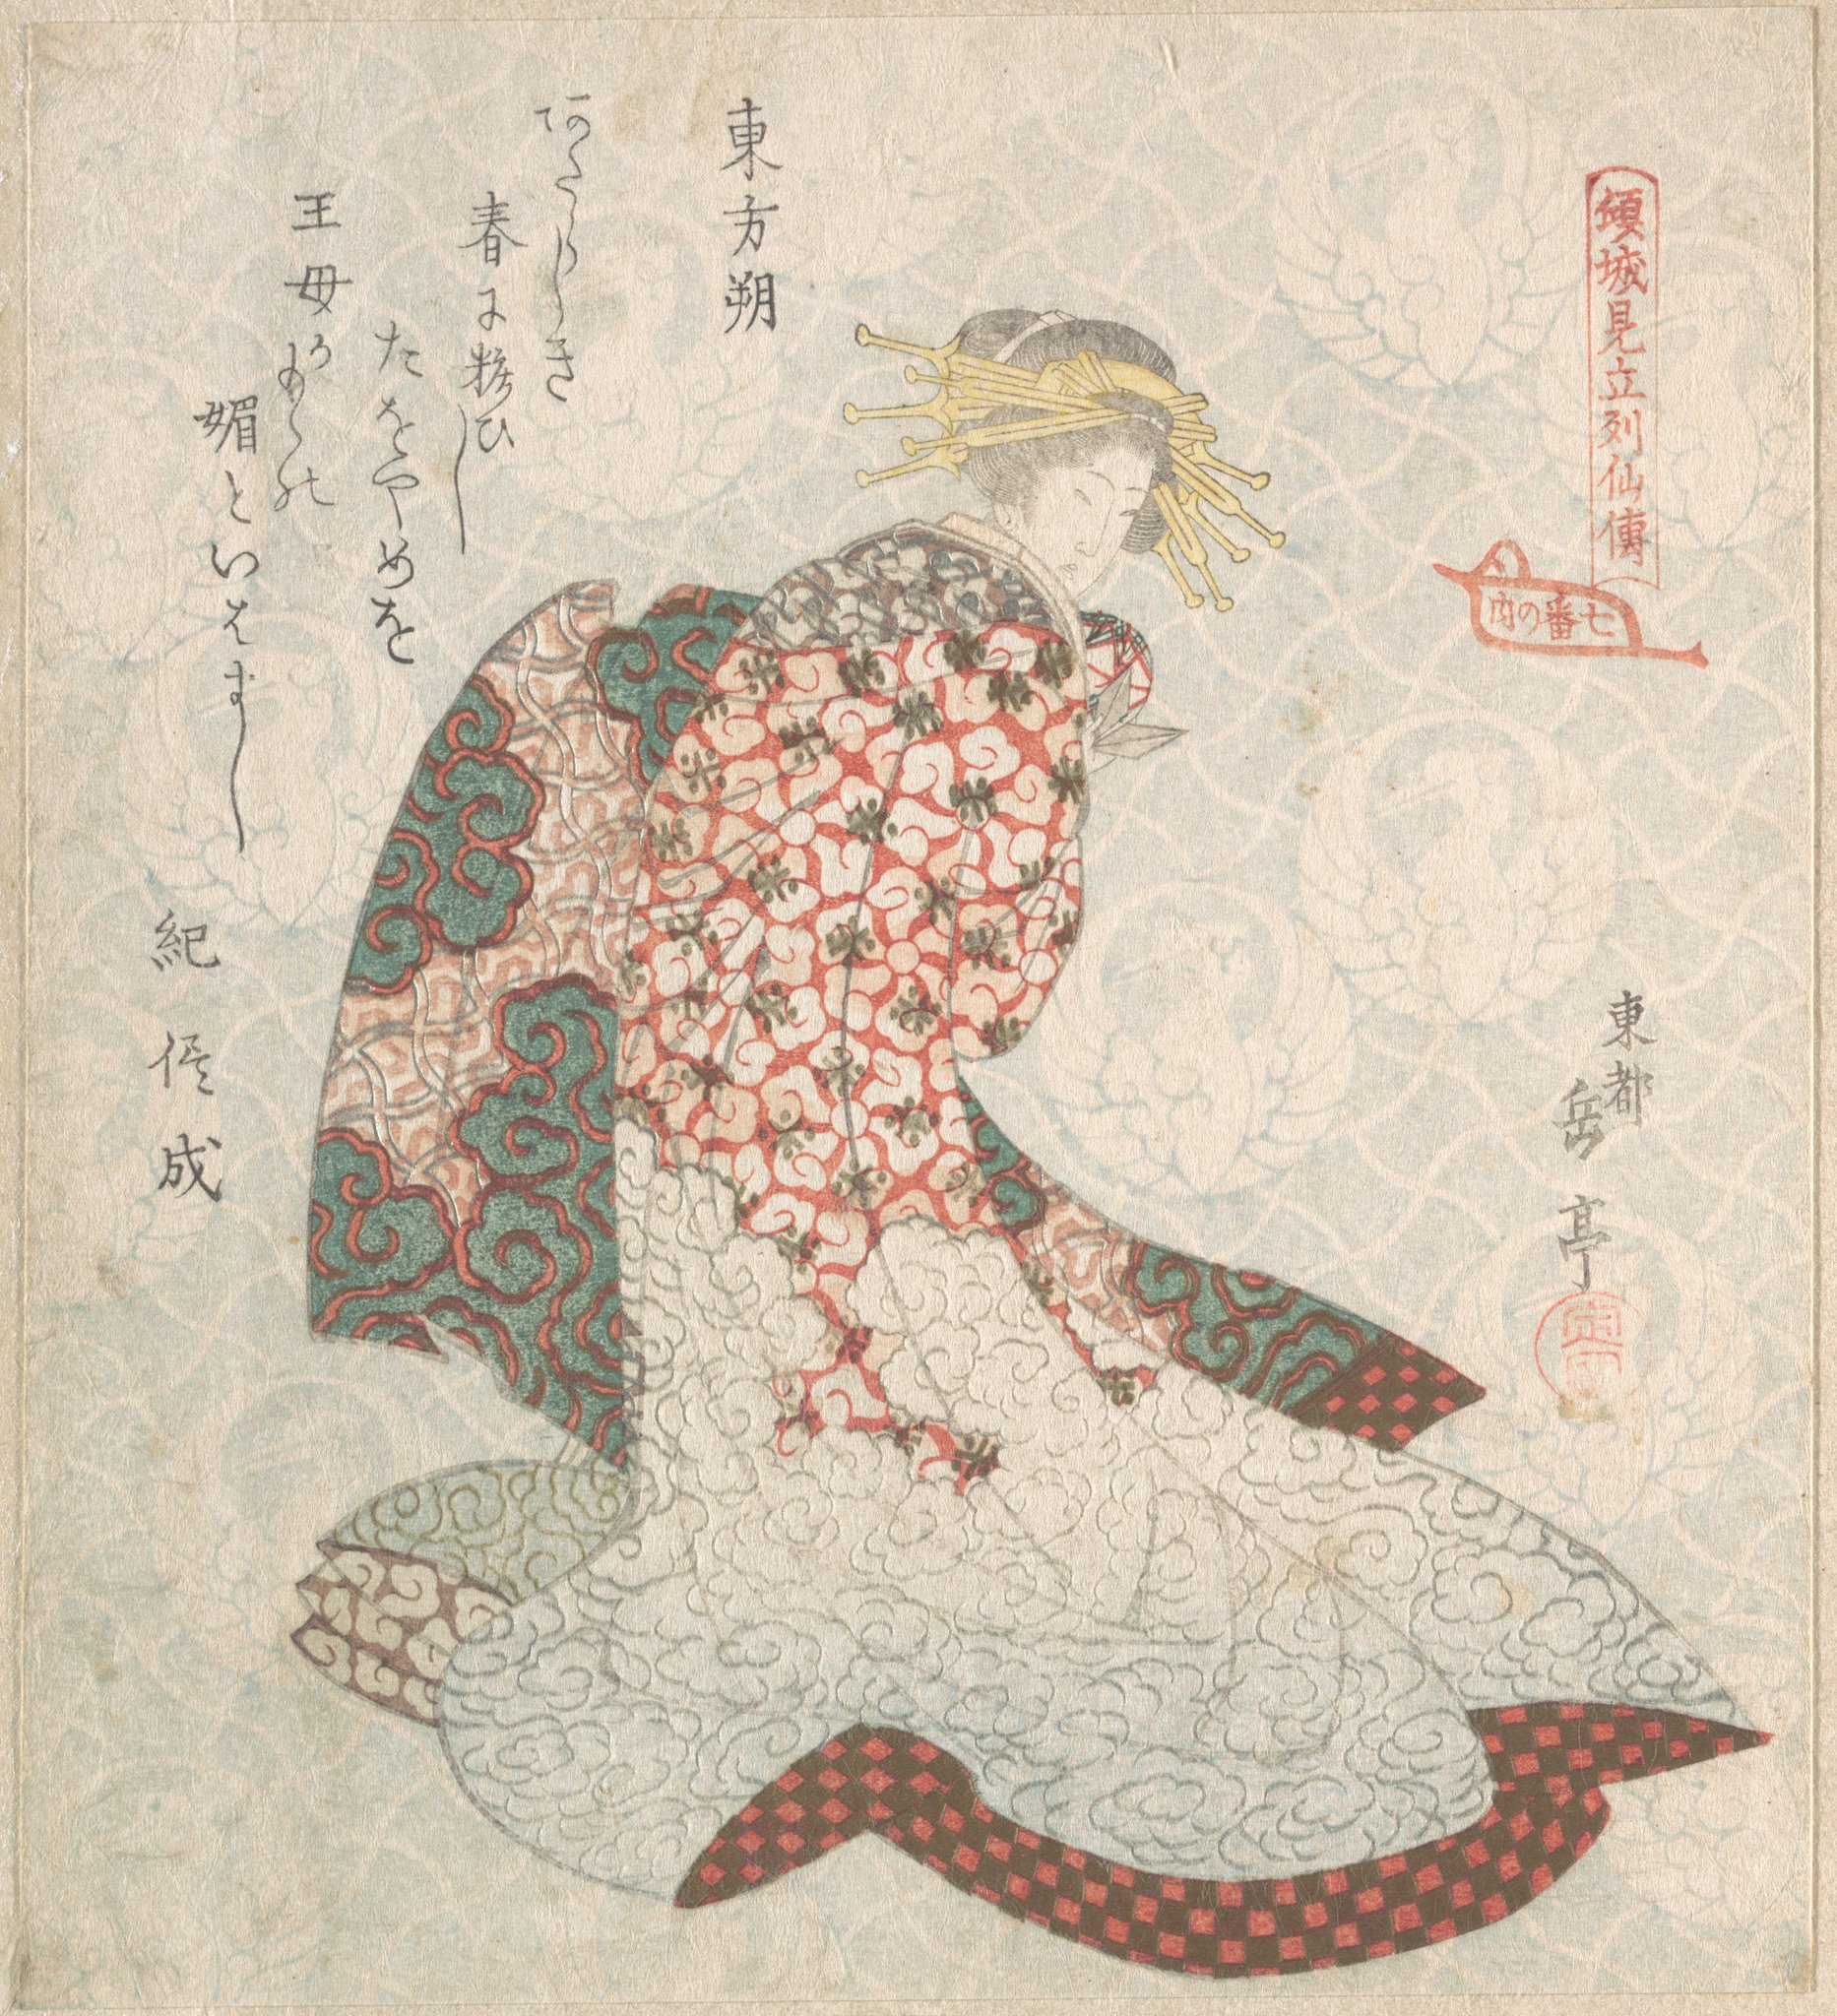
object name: print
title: Courtesan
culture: japanese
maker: yashima gakutei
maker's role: artist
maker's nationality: japanese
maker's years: 1786-1868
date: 1801-1900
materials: ink, paper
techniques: surimono, woodblock print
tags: women